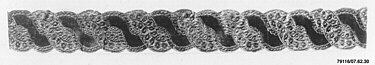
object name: ribbon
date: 1701-1800